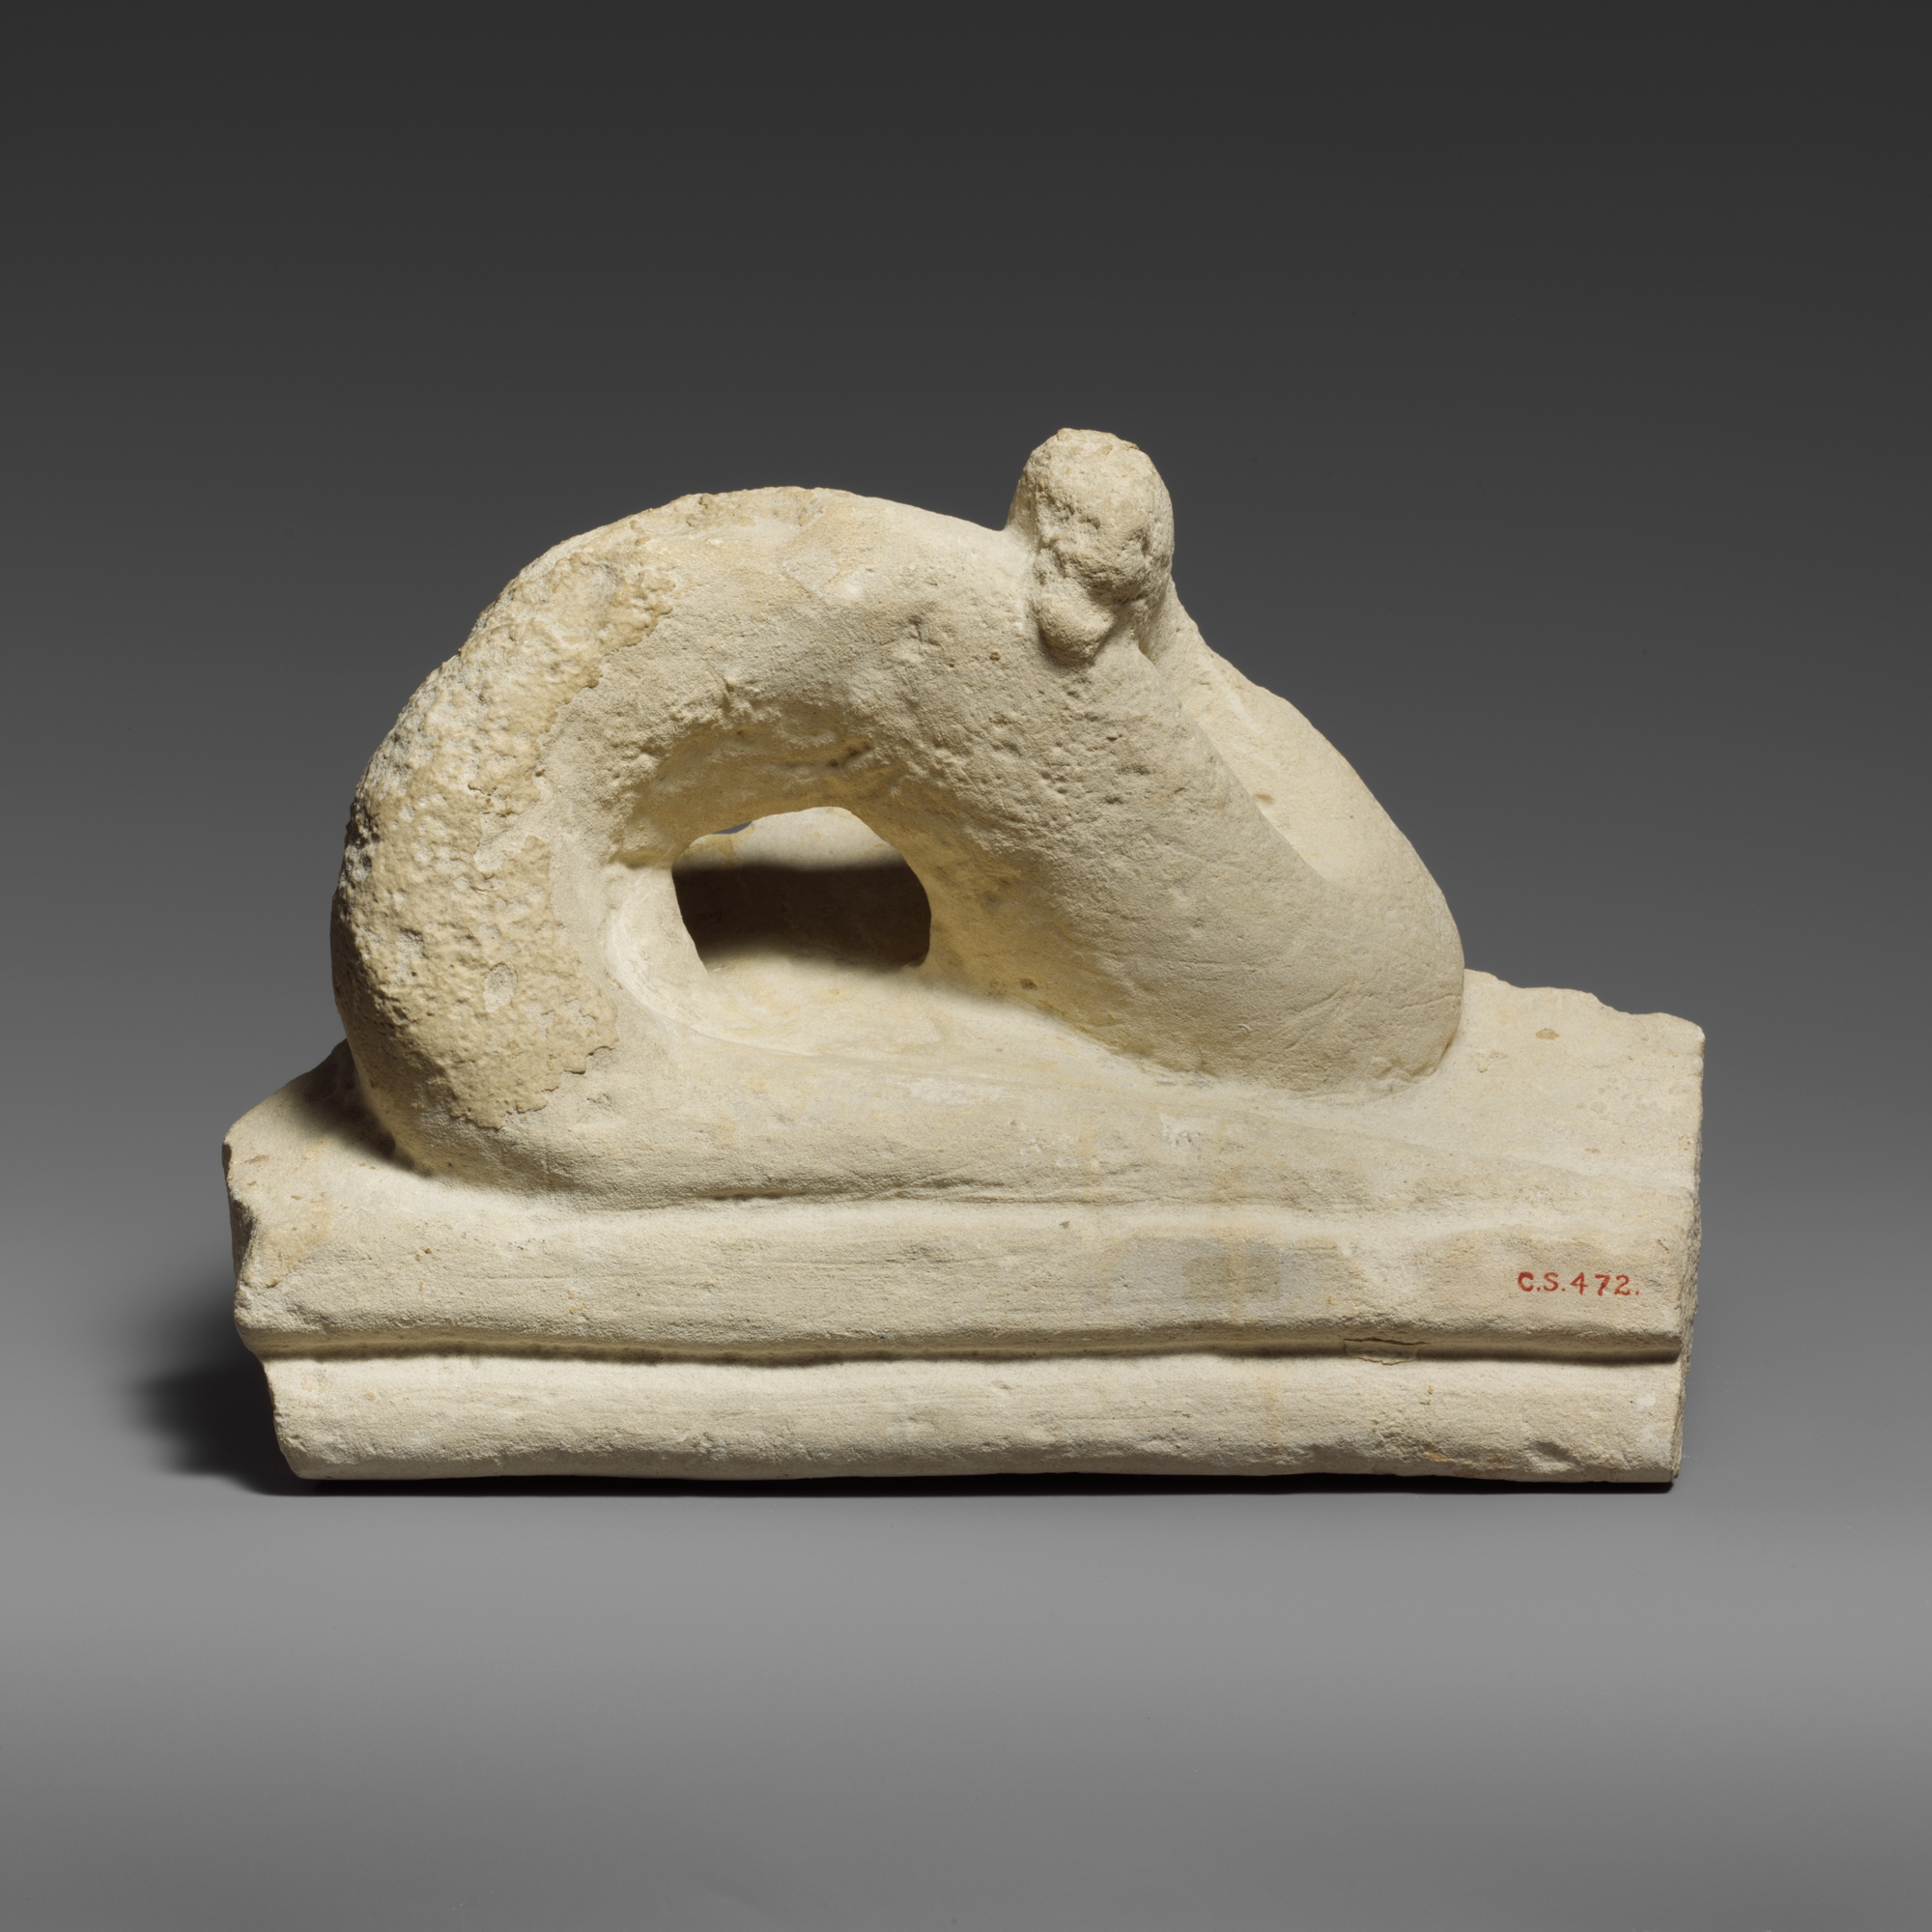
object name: statuette of a snake, coiled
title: Two fragments of a limestone sarcophagus lid with snakes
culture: cypriot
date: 500-451 BCE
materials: limestone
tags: snakes